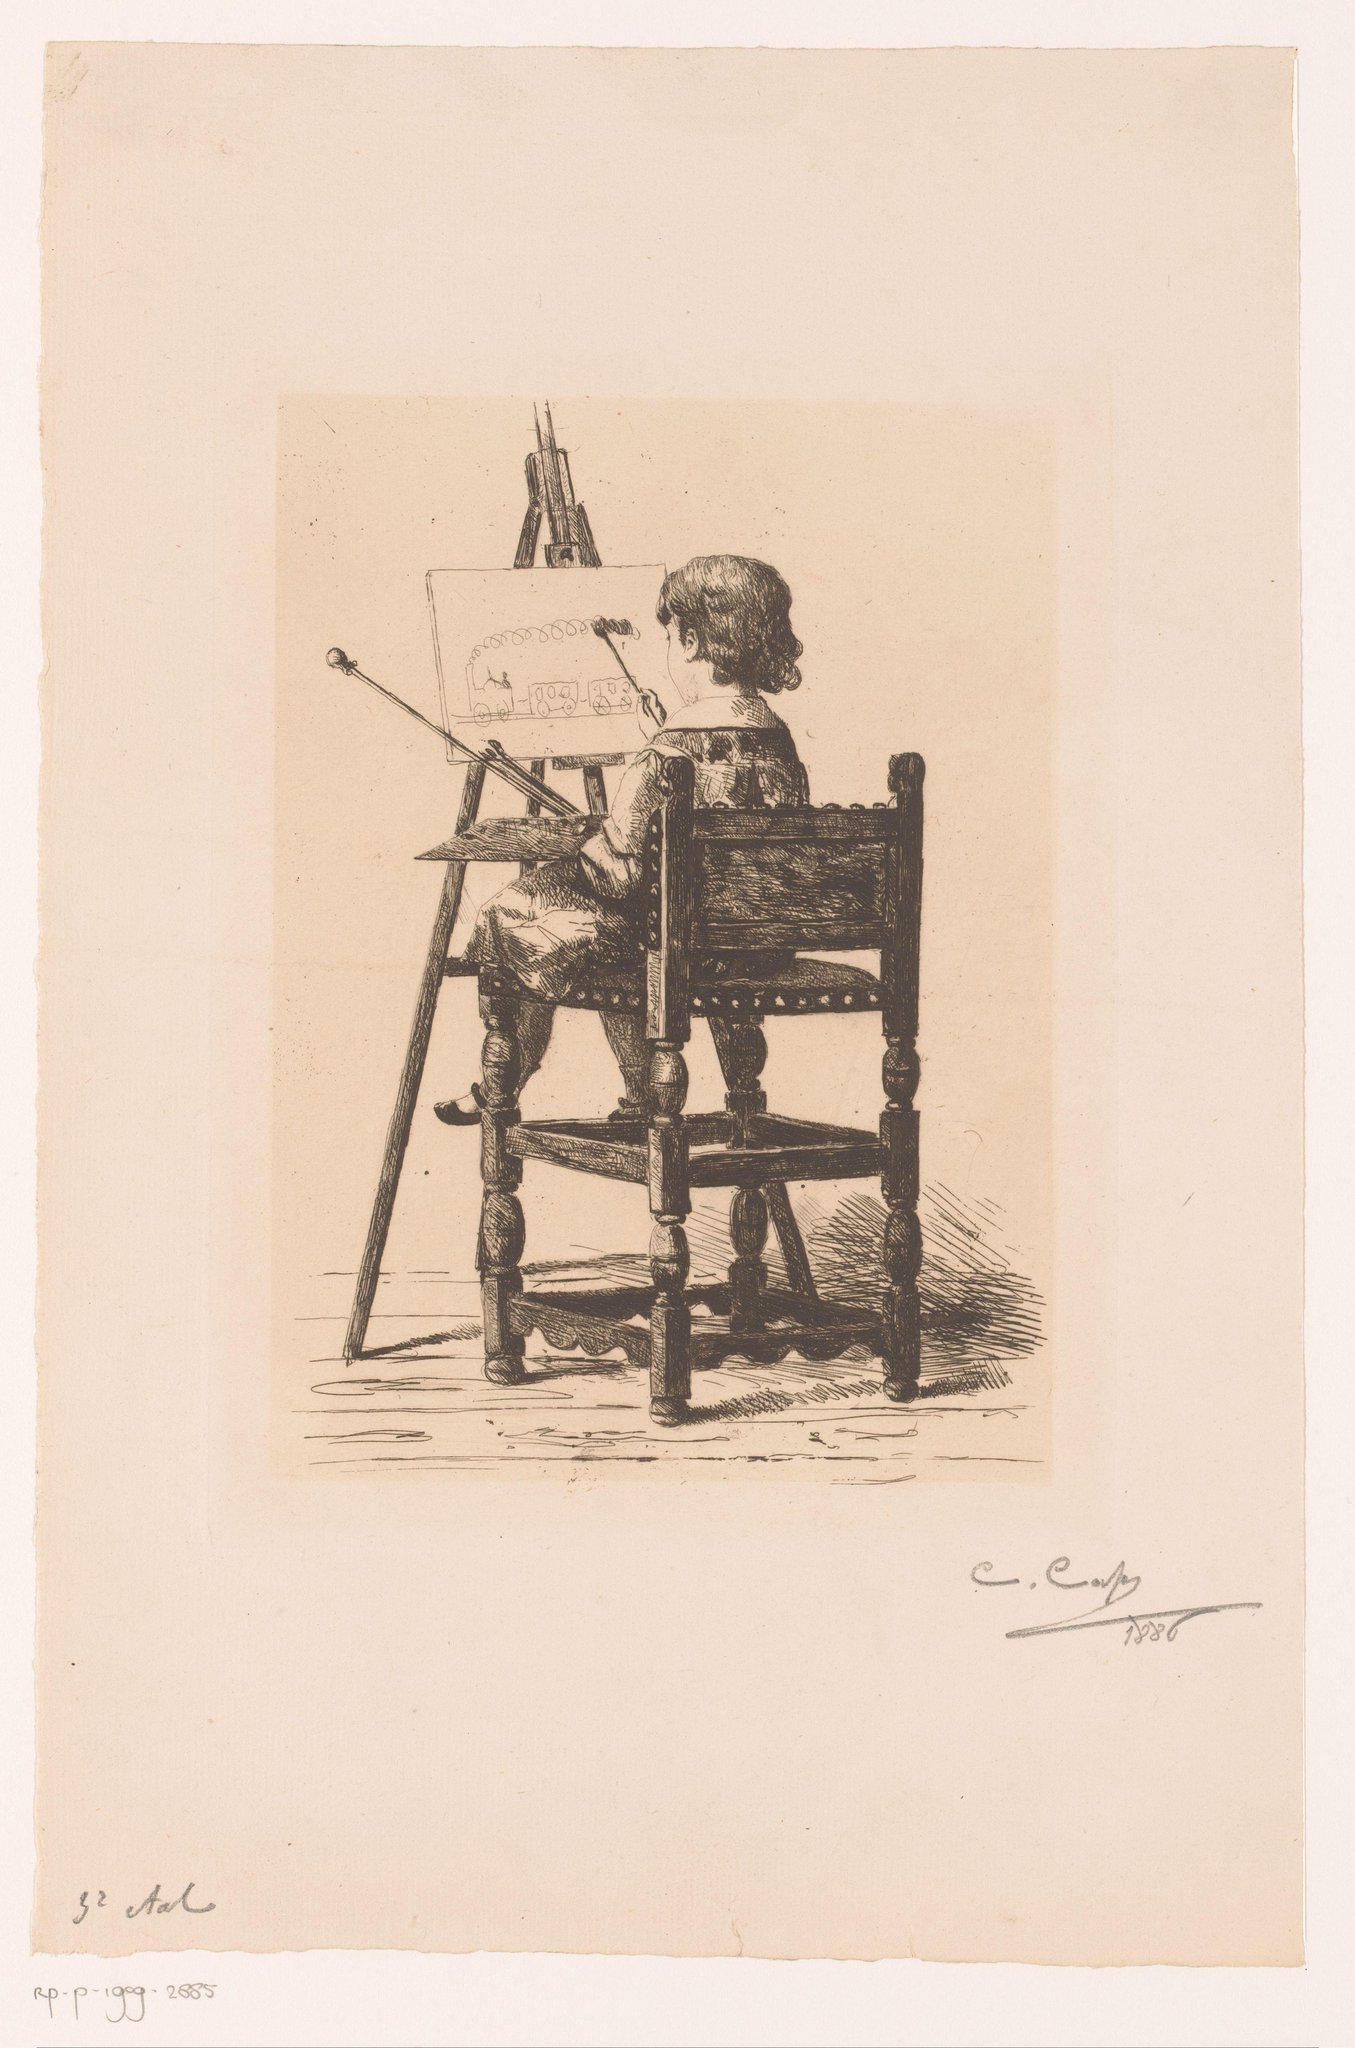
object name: print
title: Meisje voor een schildersezel tekent een stoomtrein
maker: constant aimé marie cap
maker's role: print maker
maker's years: 1842-1915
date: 1886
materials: paper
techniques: drypoint, etching, intaglio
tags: painter at work, in his studio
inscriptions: annotation: ‘3e etat’, collector's mark: Lugt 2228